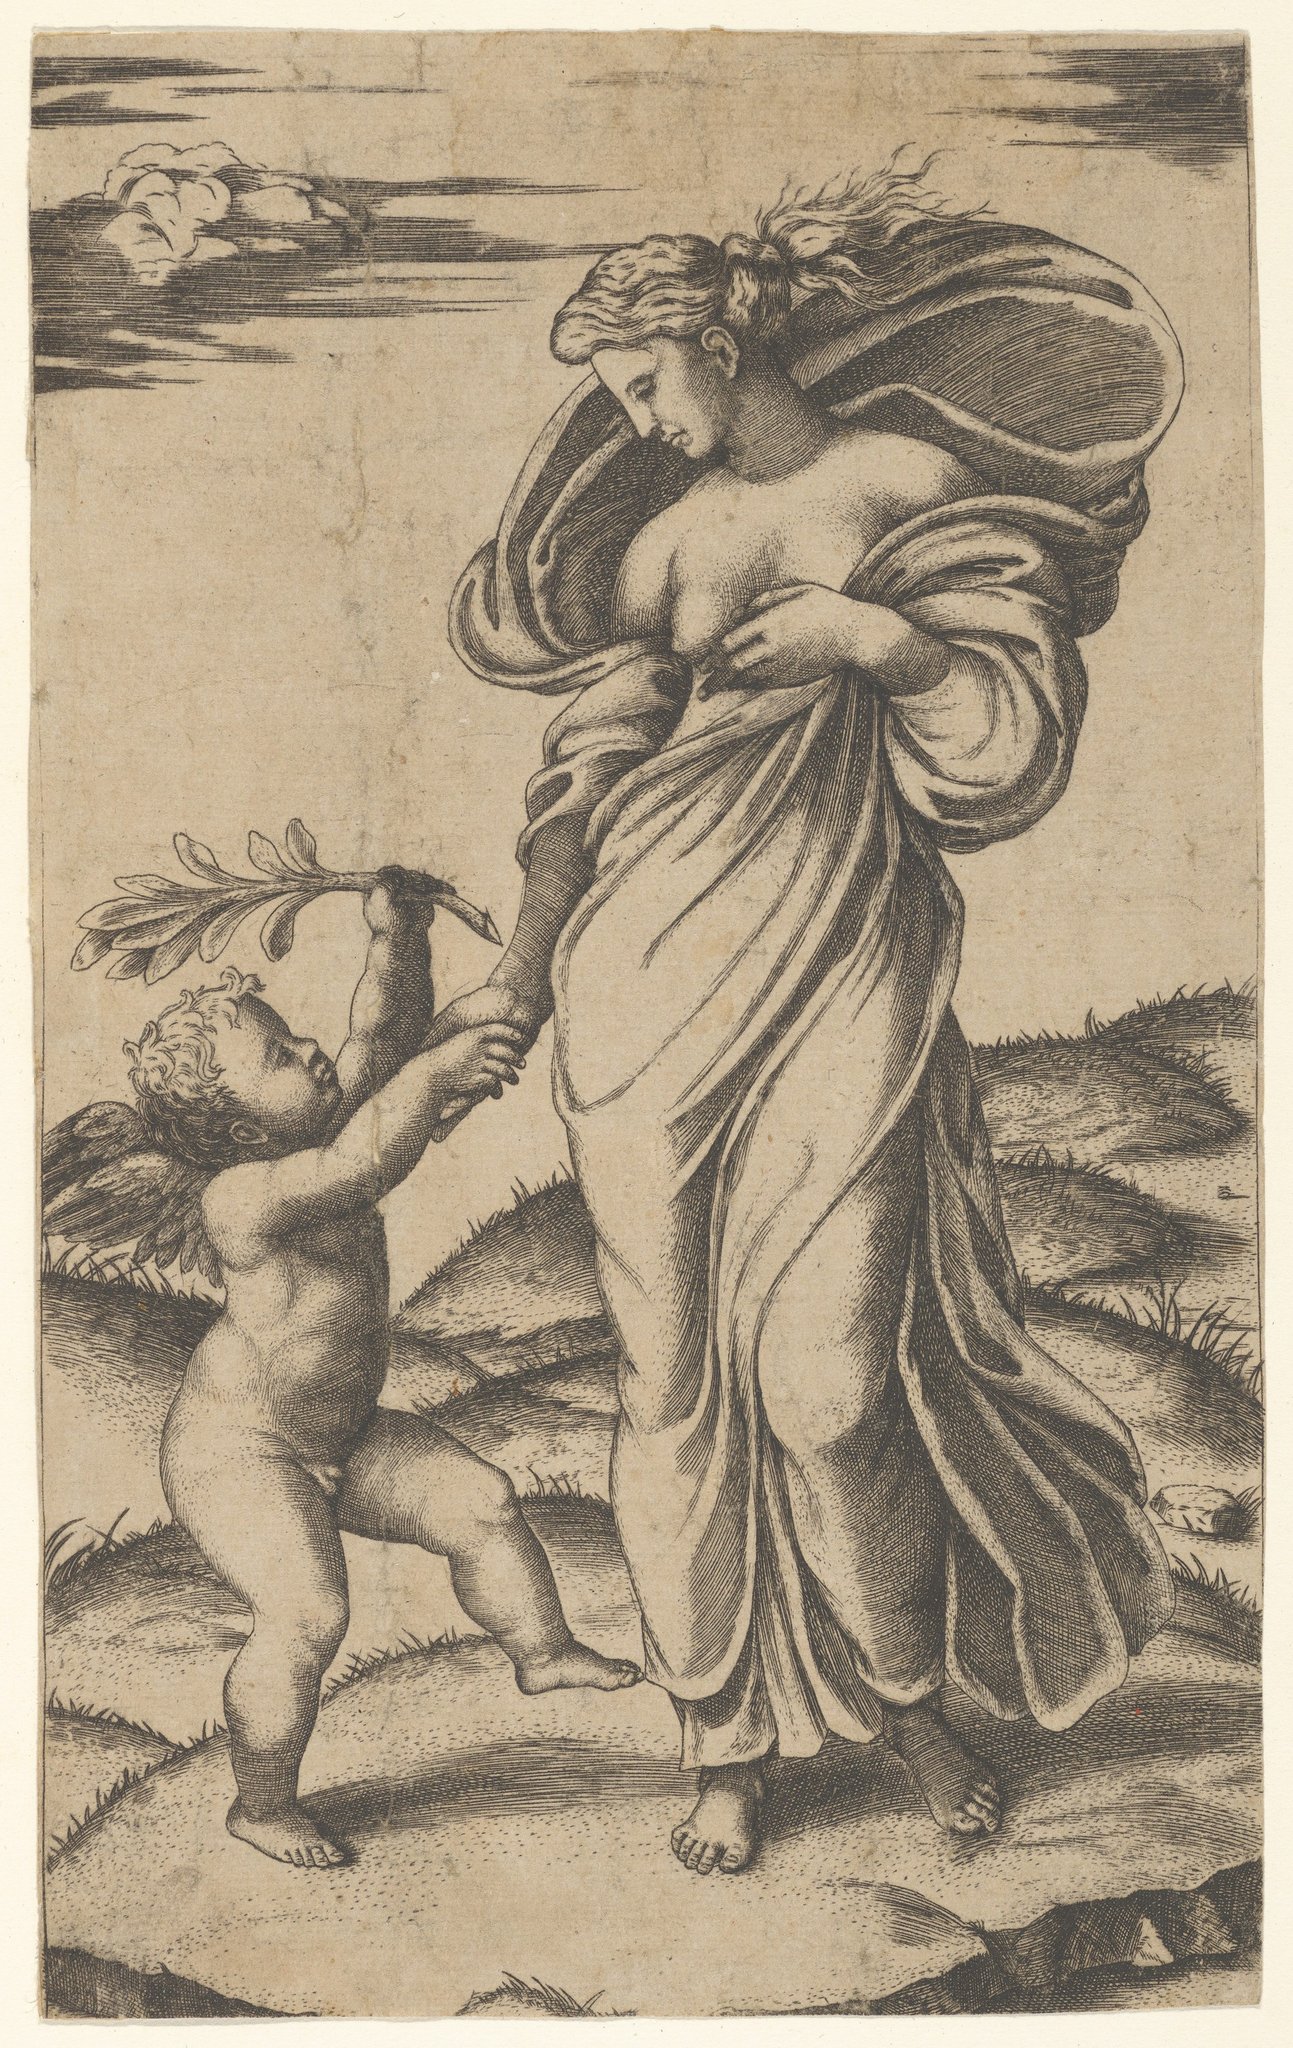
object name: print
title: An allegory of Peace; Peace personified as a woman standing in a landscape holding the left hand of a winged genius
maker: marcantonio raimondi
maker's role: artist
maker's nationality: italian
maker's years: 1475-1534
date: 1517-1520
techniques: engraving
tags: female nudes